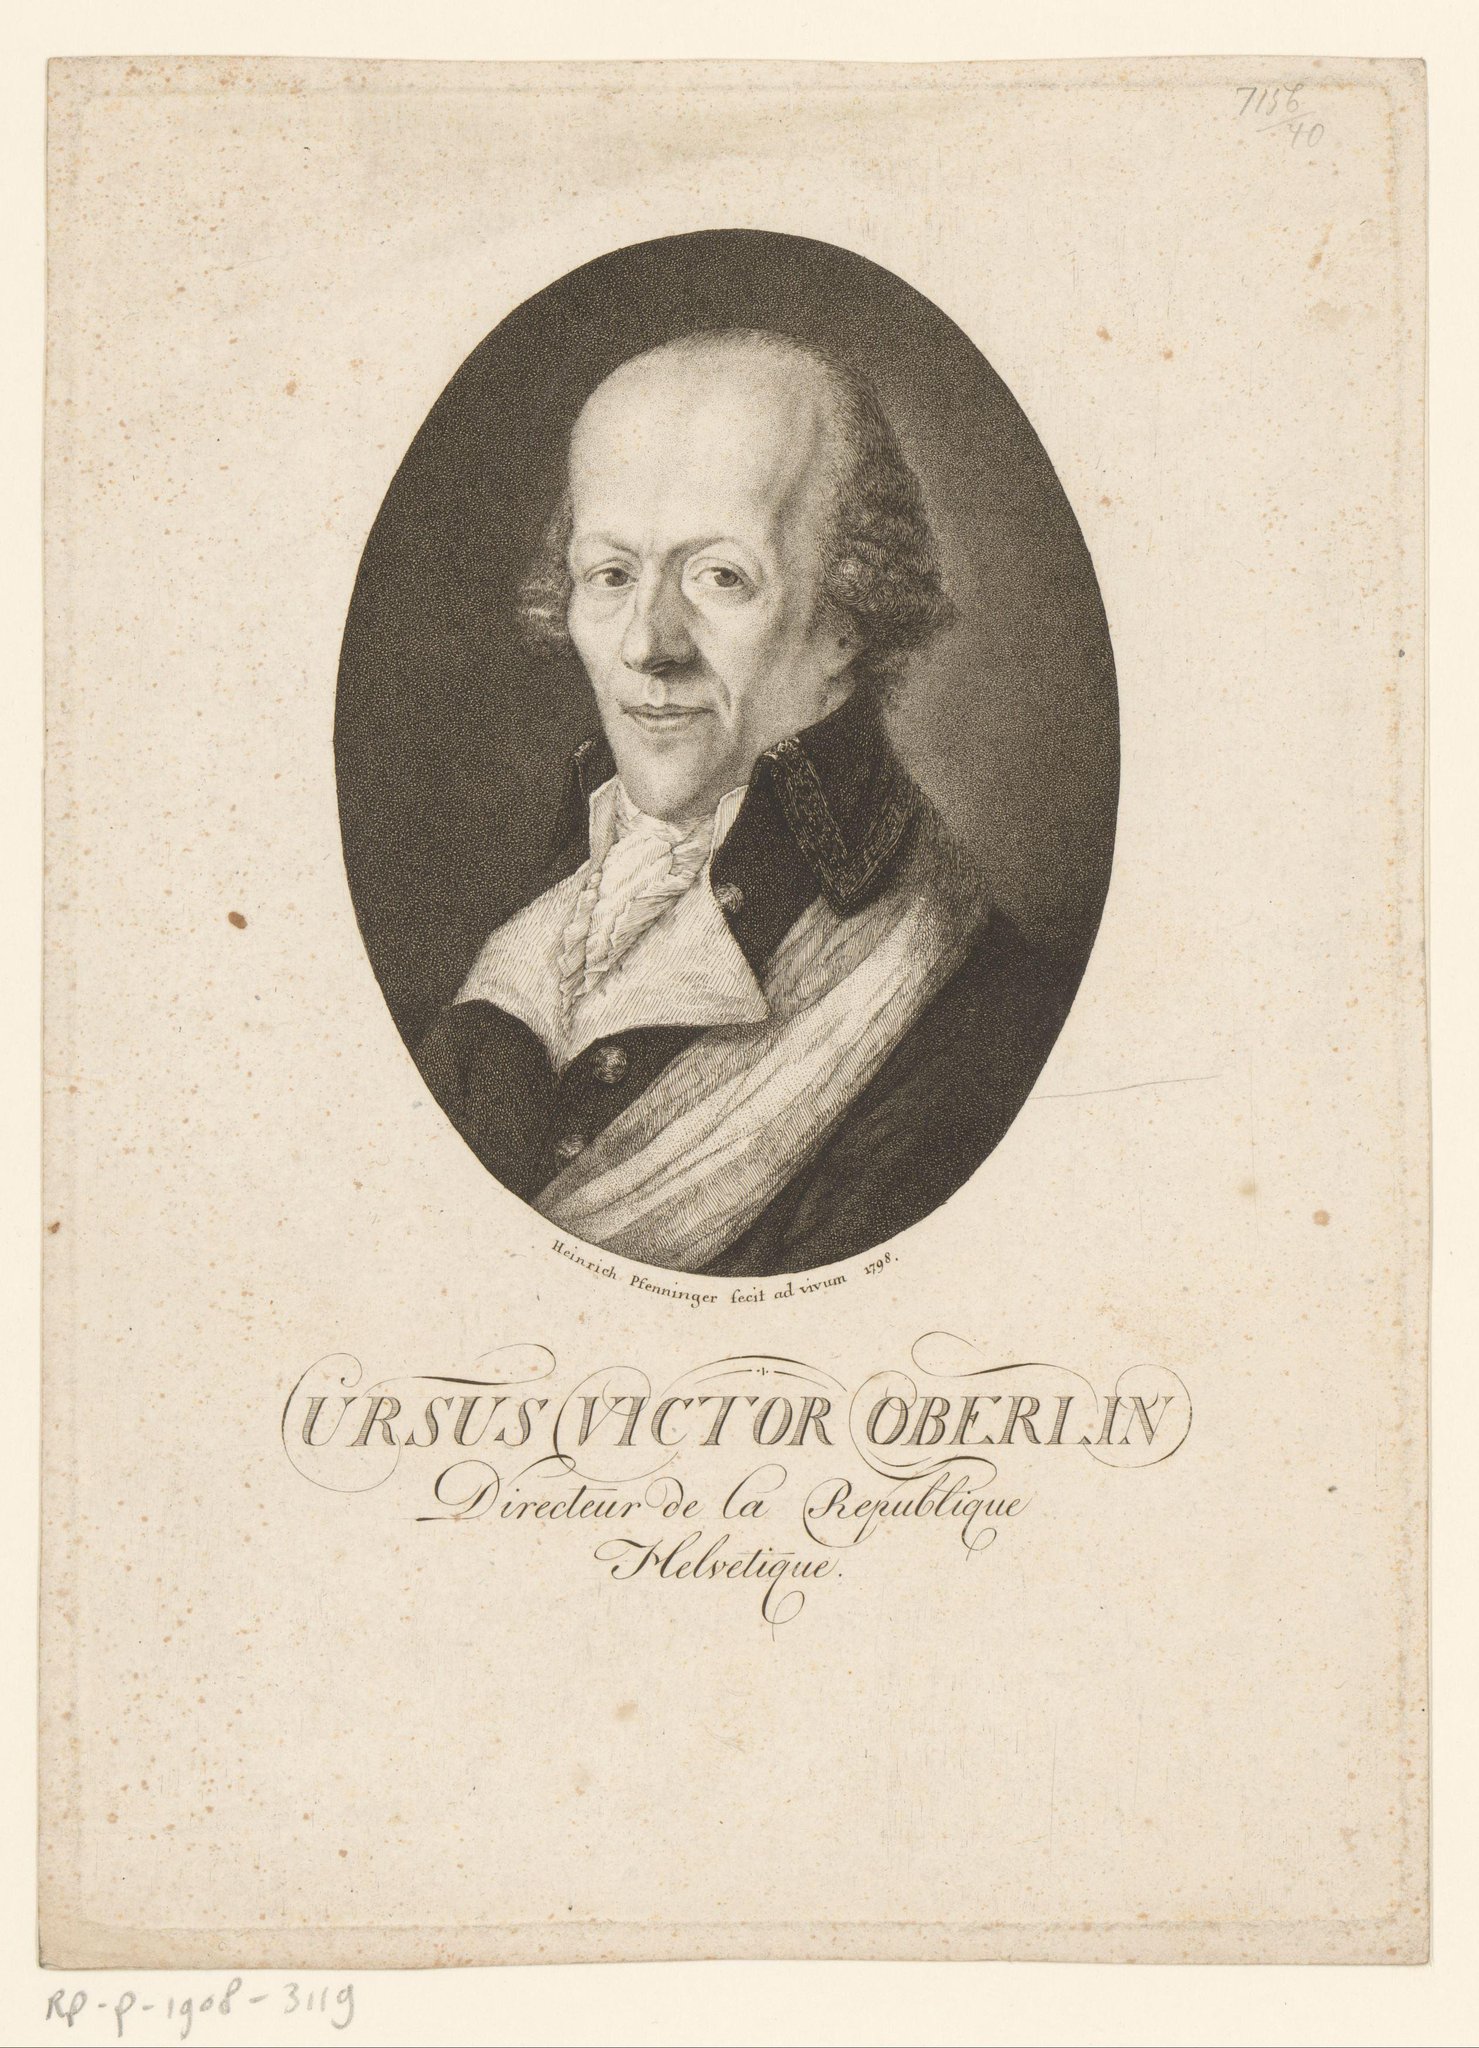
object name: print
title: Portret van Urs Viktor Oberlin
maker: heinrich pfenninger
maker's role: print maker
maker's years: 1749-1815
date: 1759-1815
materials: paper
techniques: etching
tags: politician, historical persons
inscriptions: collector's mark: Lugt 2228